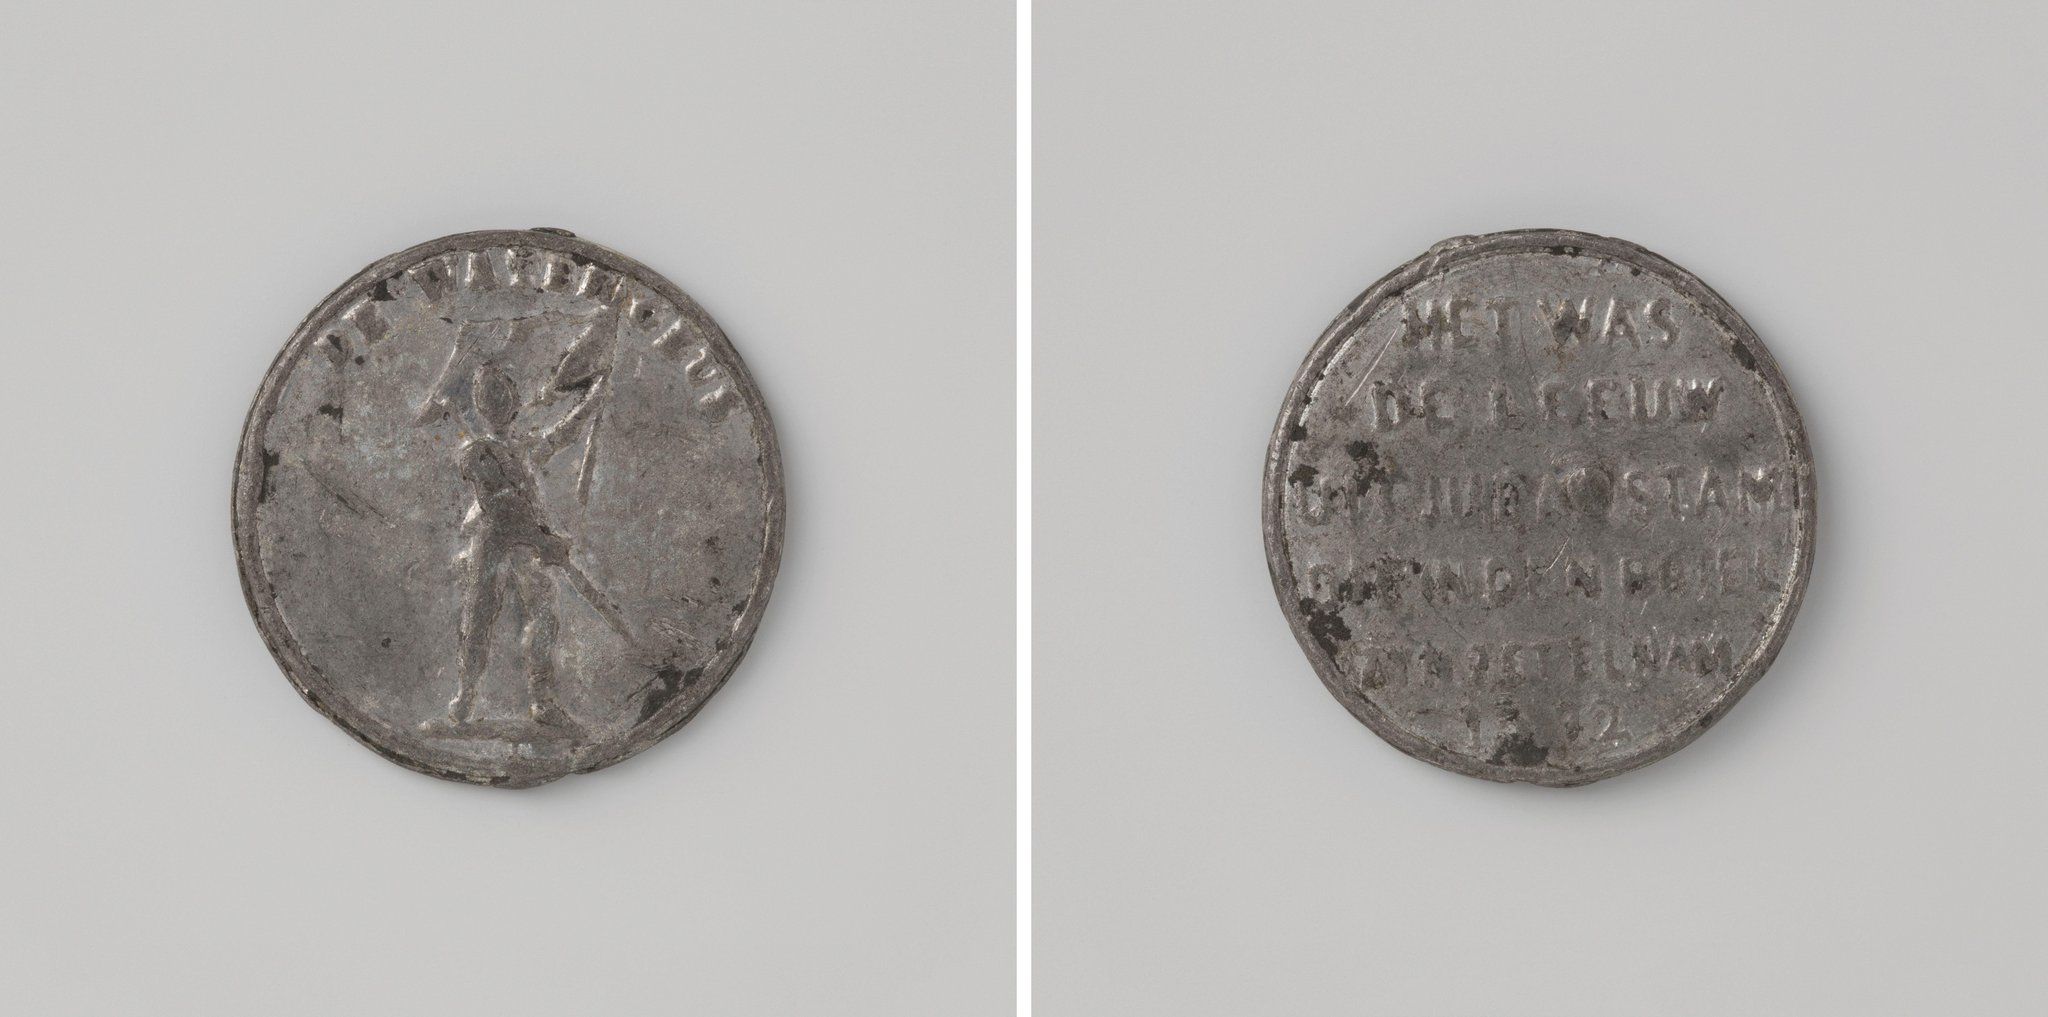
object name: history medal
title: Driehonderdjarige herdenking van de inname van Den Briel door de Watergeuzen 1872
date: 1872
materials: tin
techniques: casting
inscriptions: inscription: ‘HET WAS / DE LEEUW / UIT JUDA'S STAM / DIE IN DEN BRIEL / ZYN ZETEL NAM / 1572’, circumscription: ‘DE WATERGEUS’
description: Gegoten tinnen penning, op de voorzijde een watergeus met vlag, bovenaan omschrift, op de keerzijde zes regels tekst.